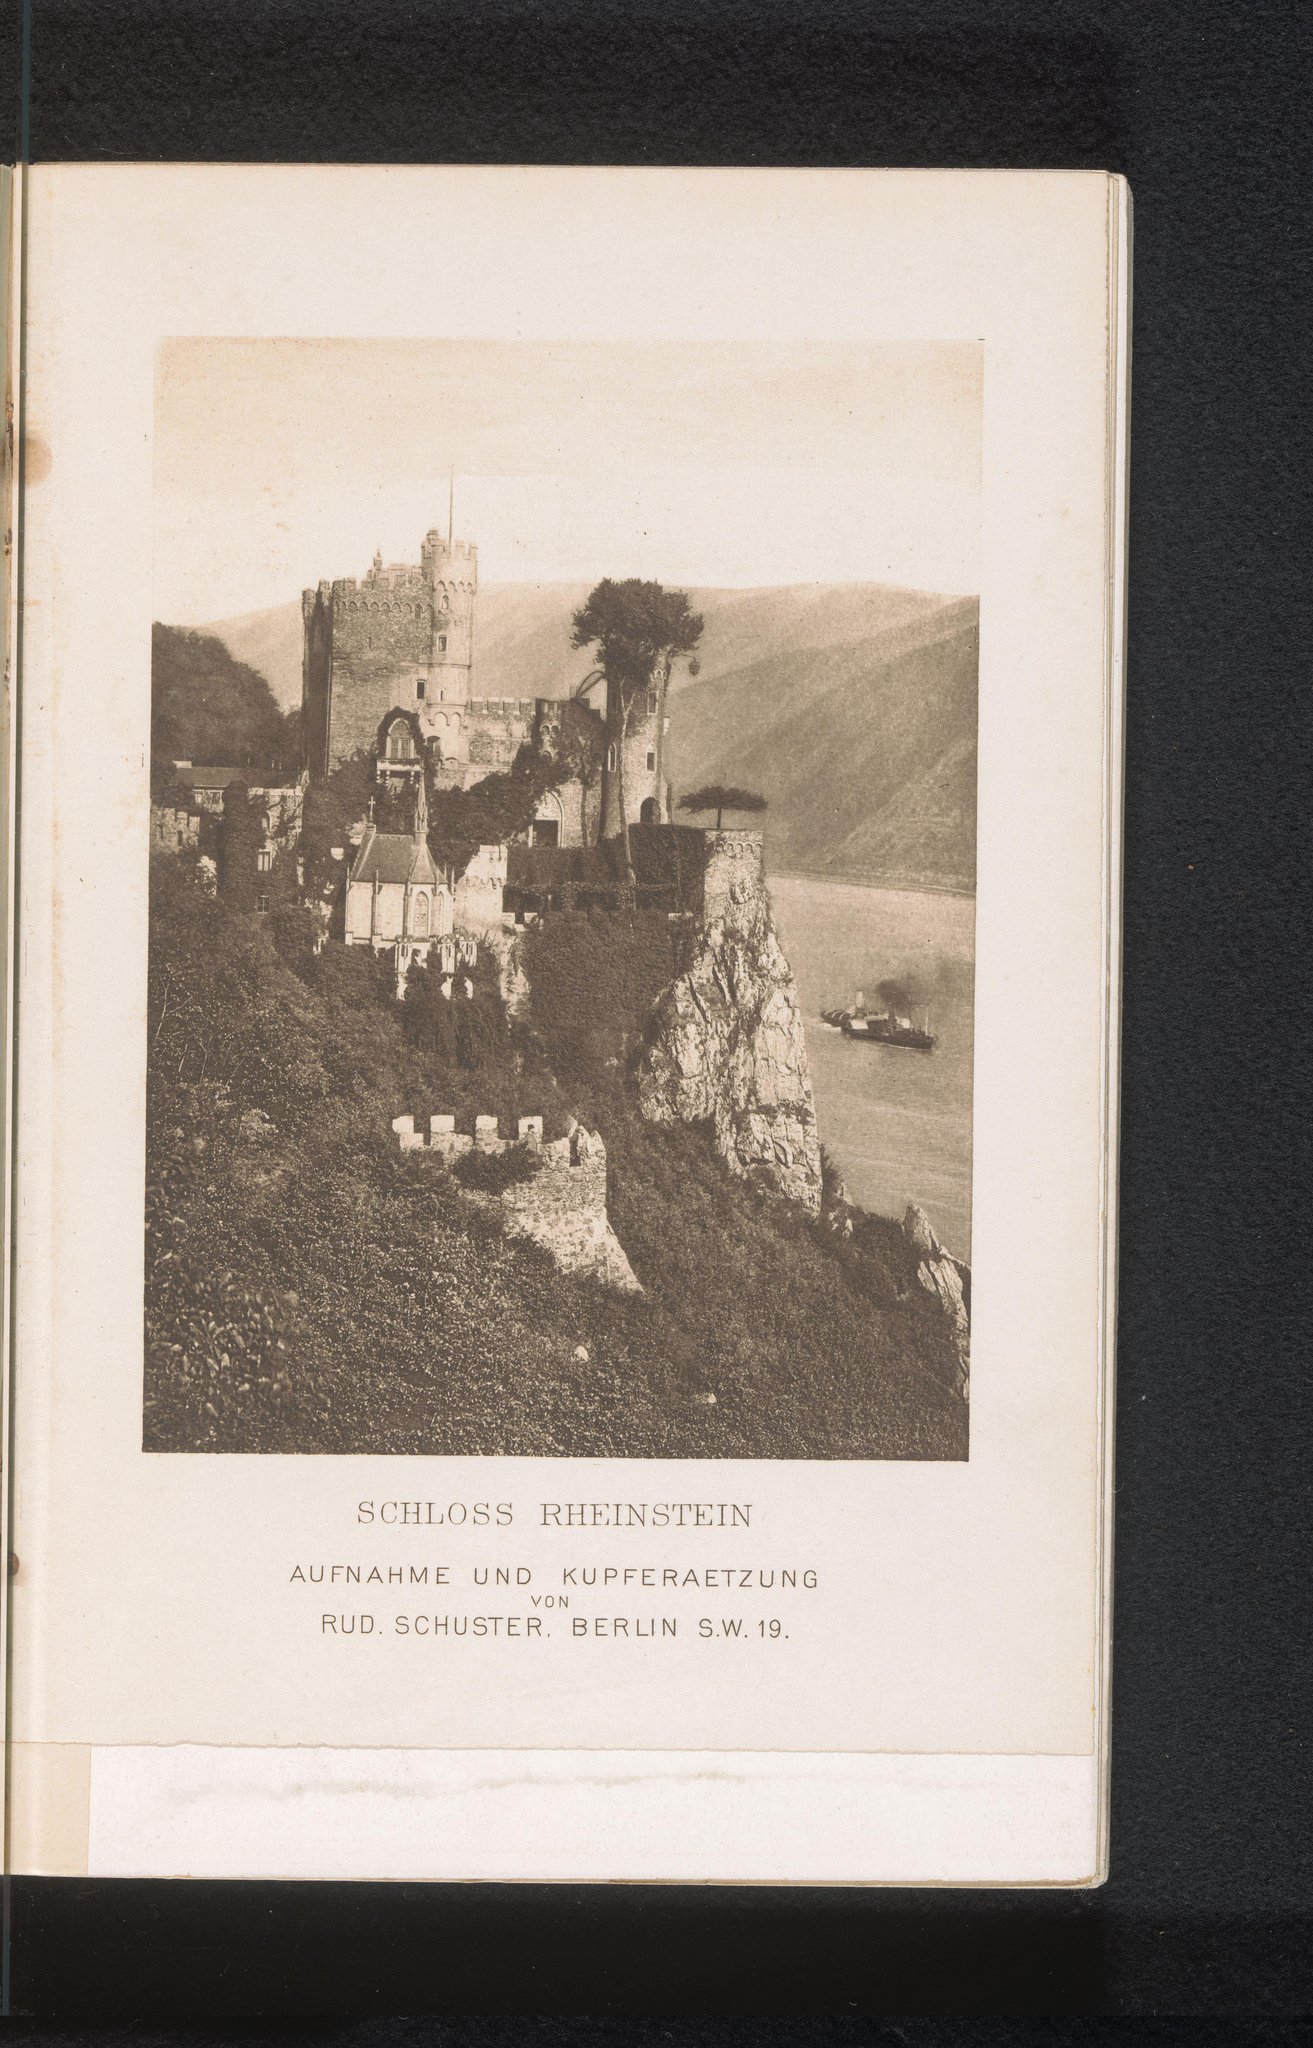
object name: photomechanical print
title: Gezicht op Burcht Rheinstein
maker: rudolf schuster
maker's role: painter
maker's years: 1848-1902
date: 1894-1899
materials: paper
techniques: photoaquatint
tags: castle, river